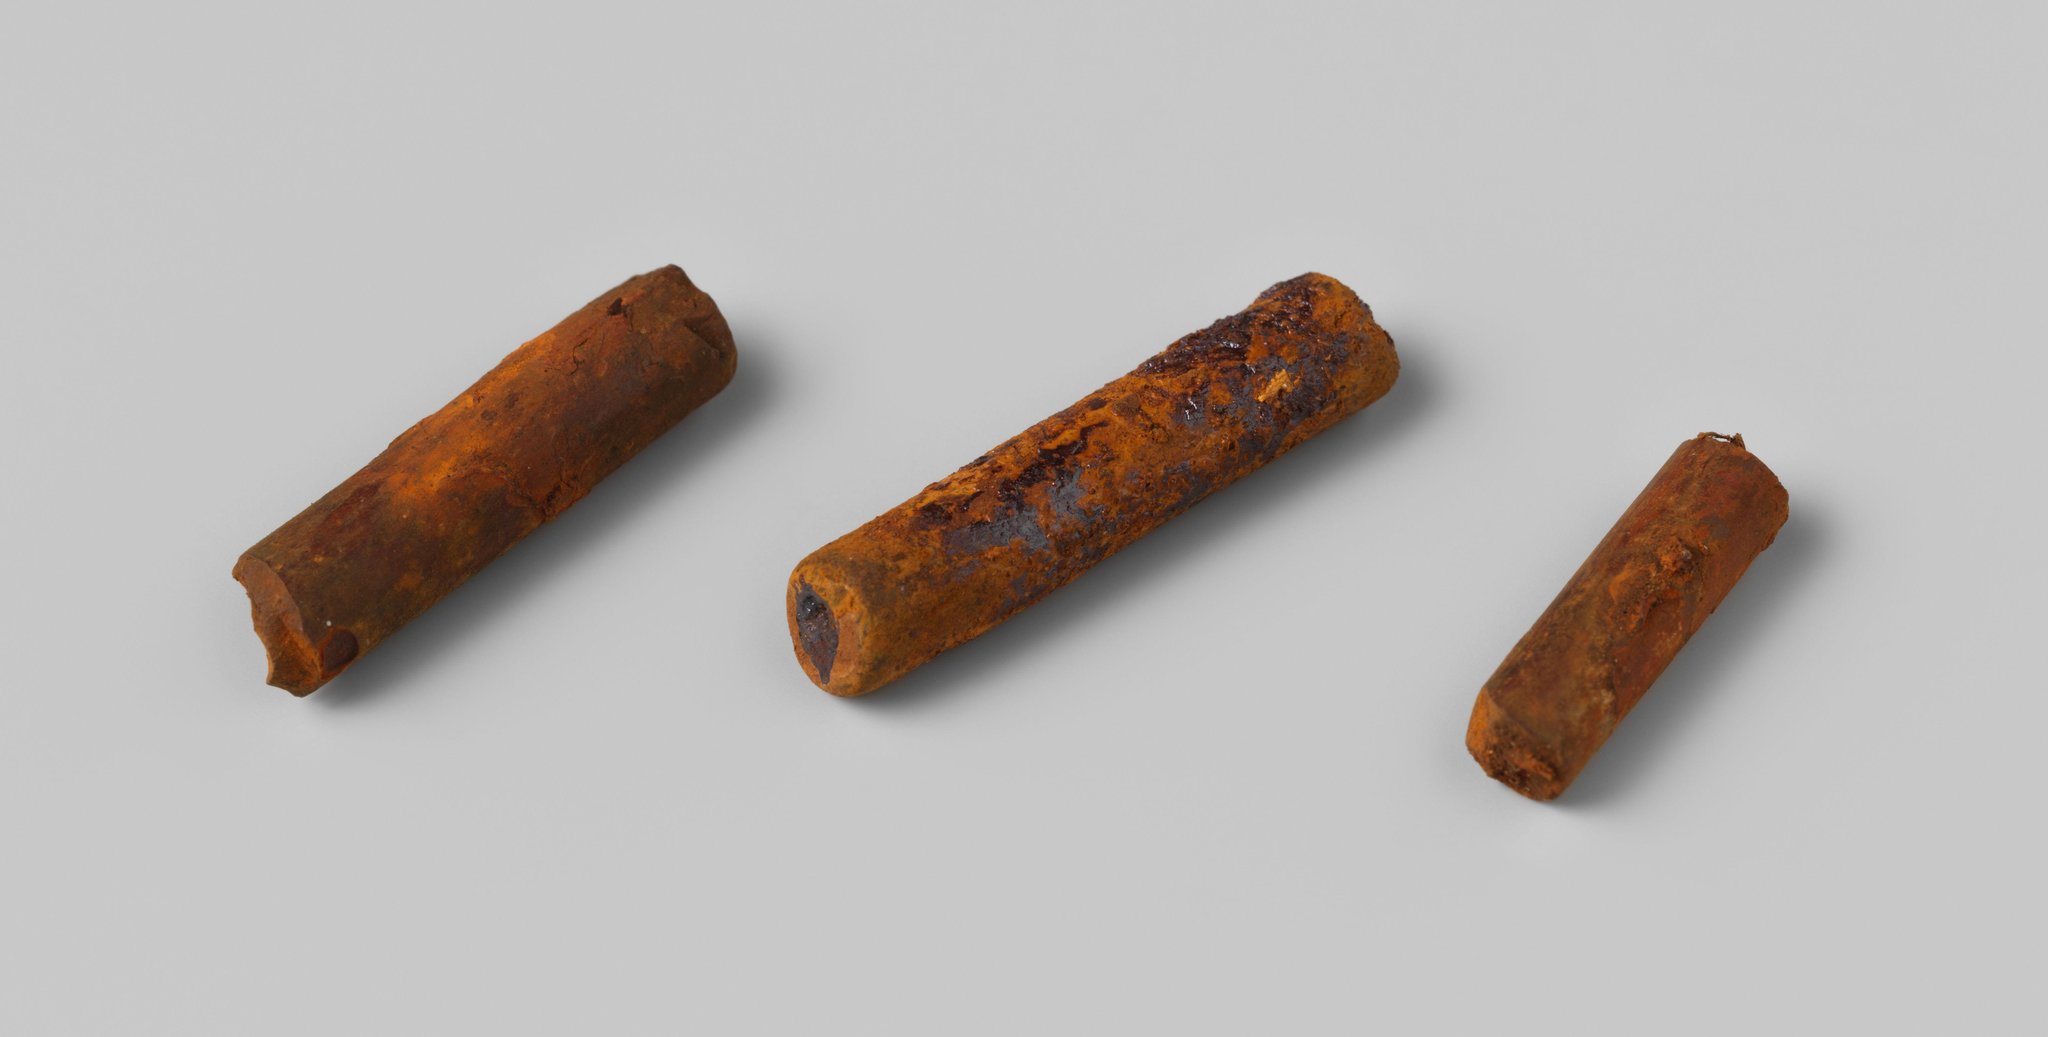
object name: pipe stem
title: Fragmenten pijpenstelen uit het wrak van de Oostindiëvaarder Hollandia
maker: Anonymous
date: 1700-1743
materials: clay